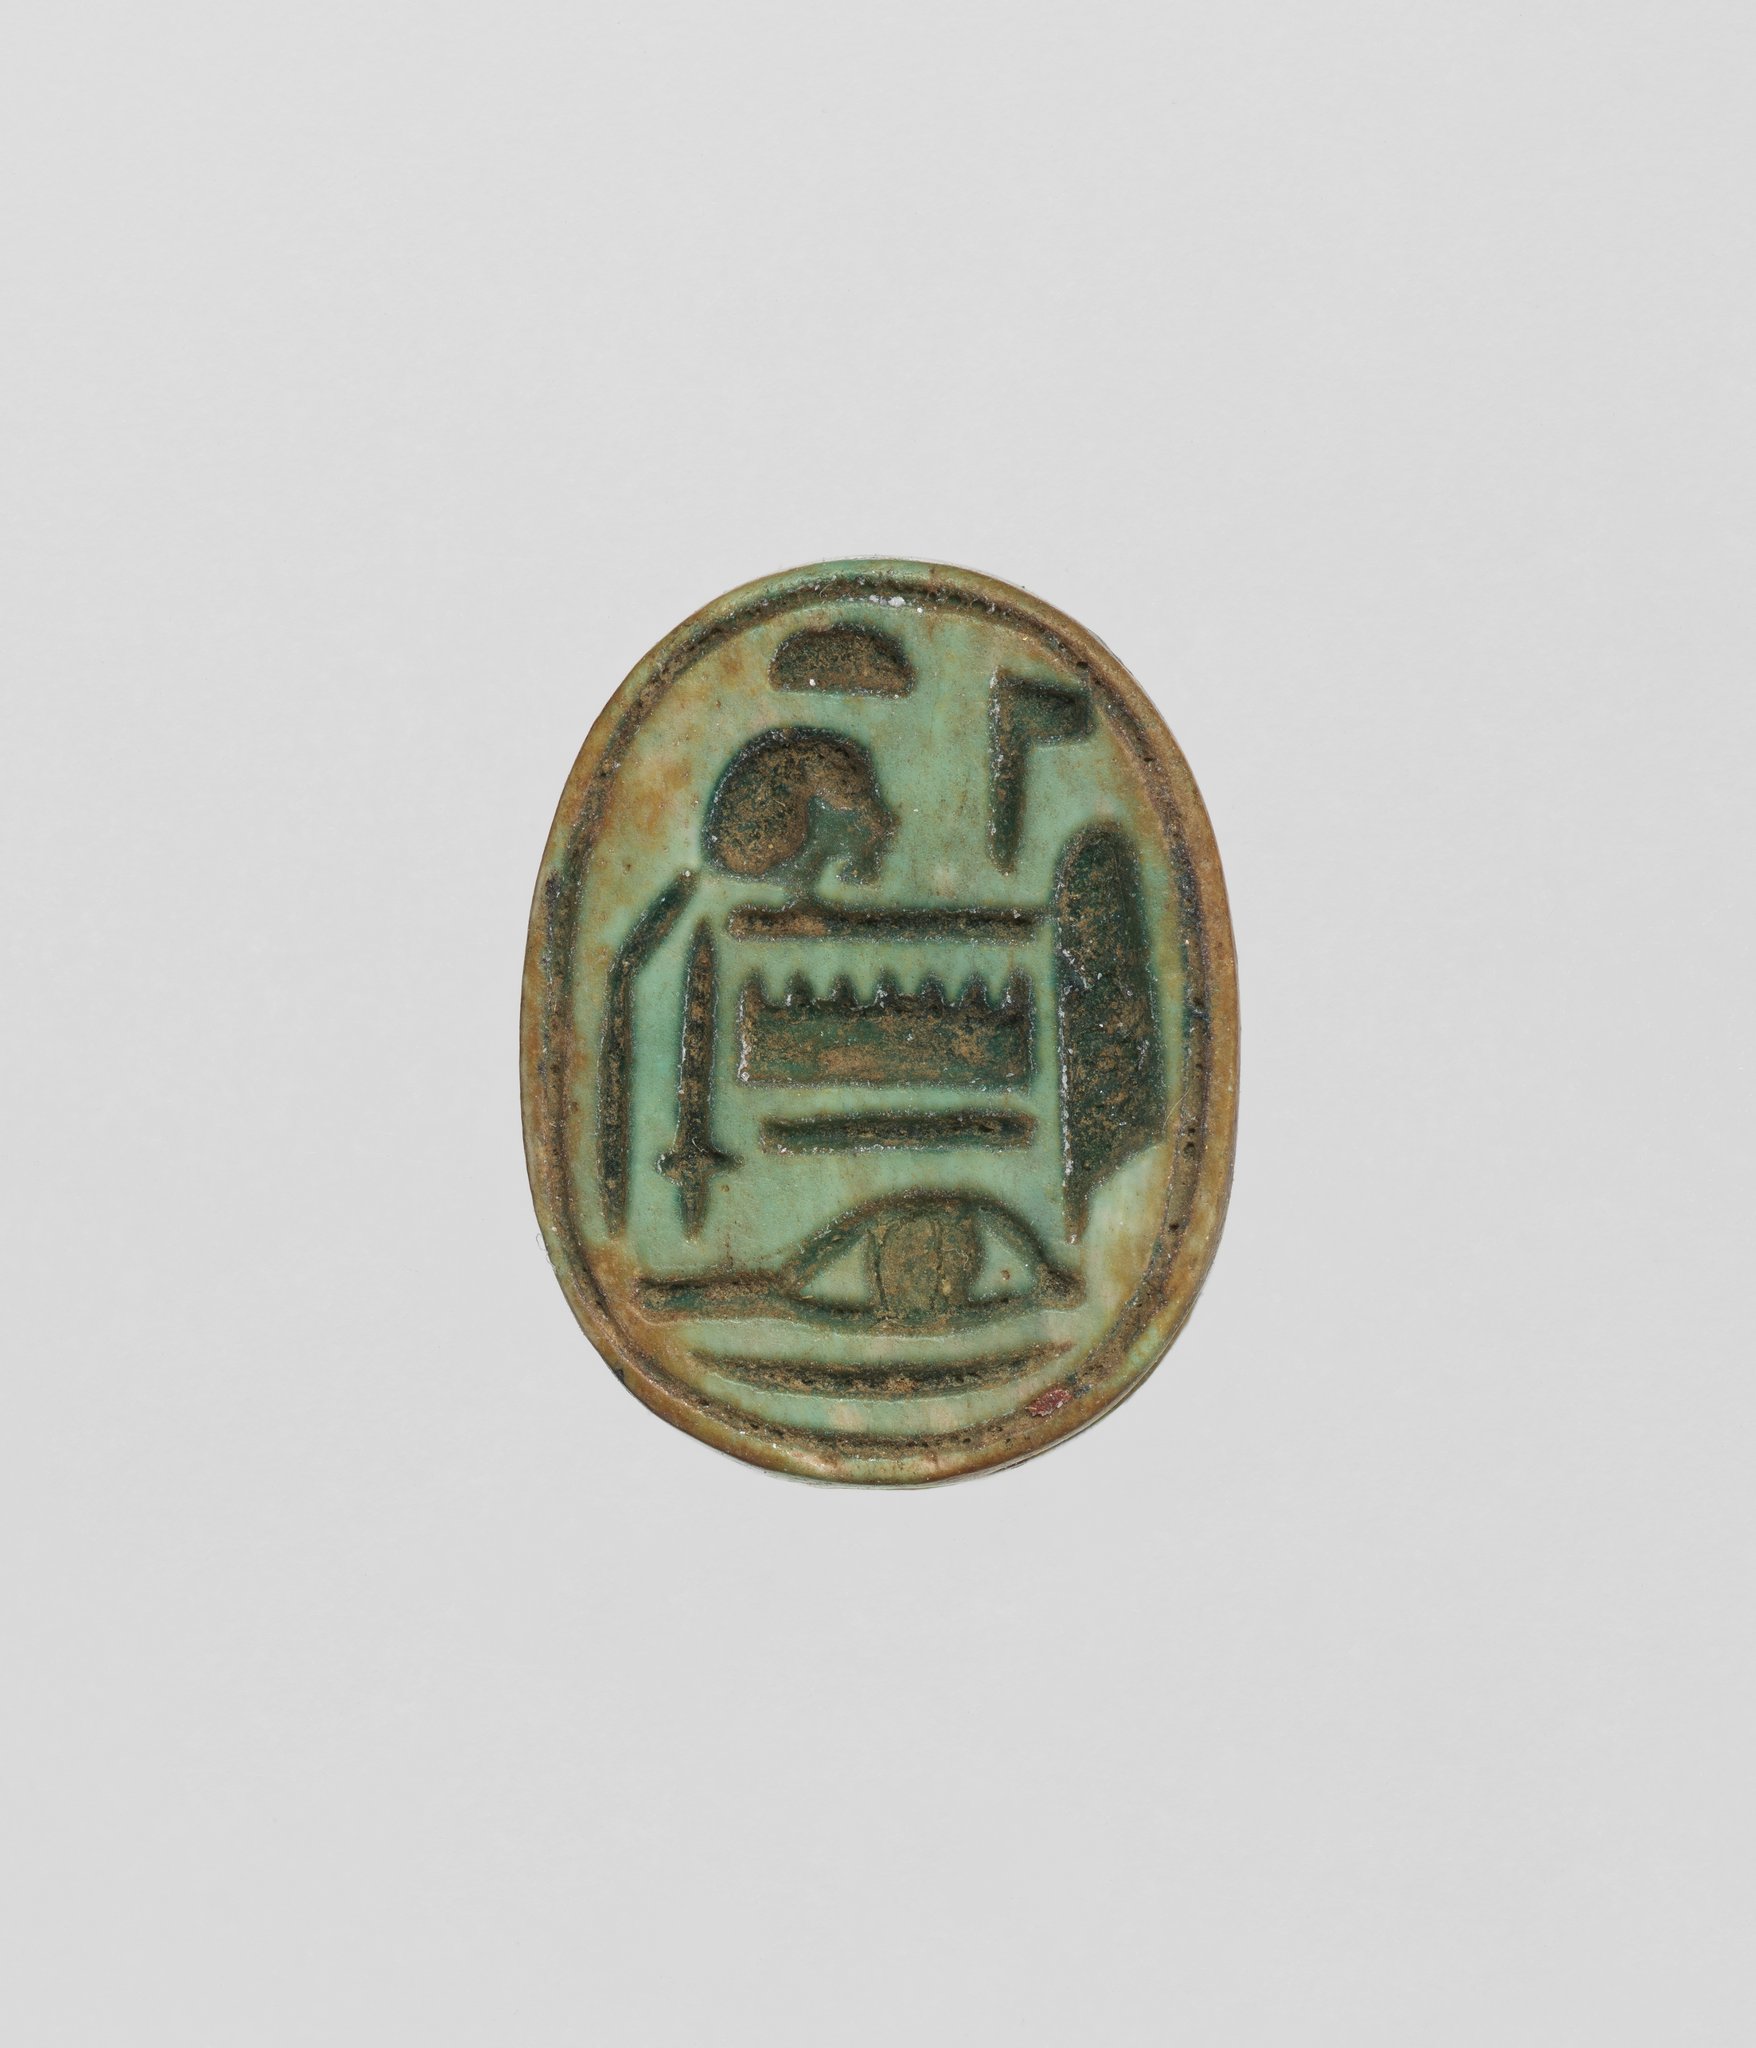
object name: scaraboid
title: Scarab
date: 1295-1070 BCE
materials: faience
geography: egypt